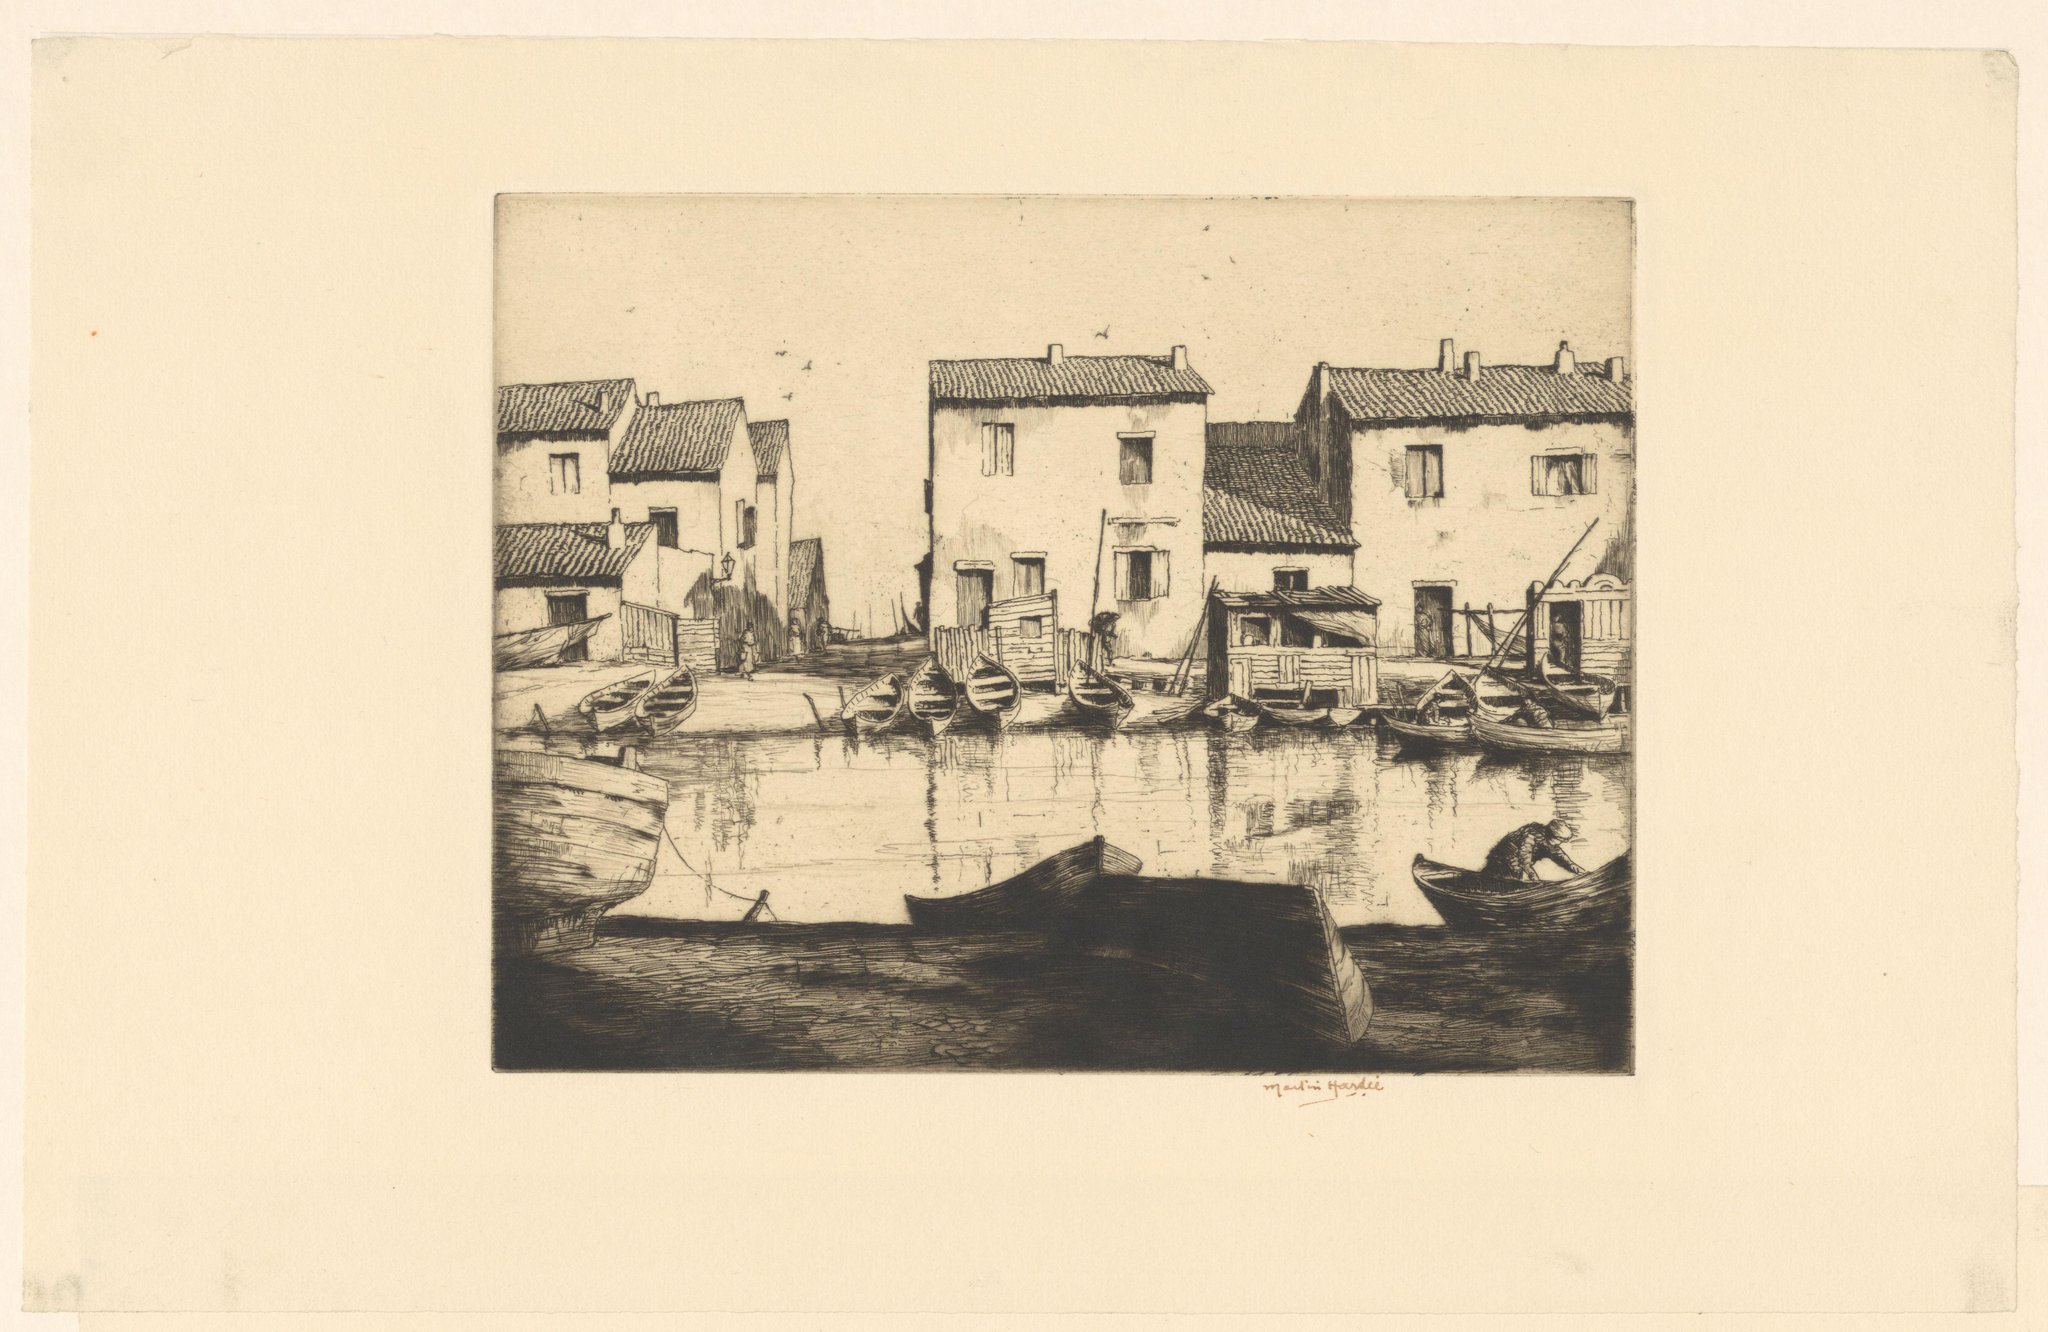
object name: print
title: Aanlegplaats met boten in Sète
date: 1924-1929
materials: paper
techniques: drypoint, etching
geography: sete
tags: village, pier, quay, wharf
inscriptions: collector's mark: Lugt 2760, annotation: ‘Martin Hardie’, collector's mark: Lugt 2228